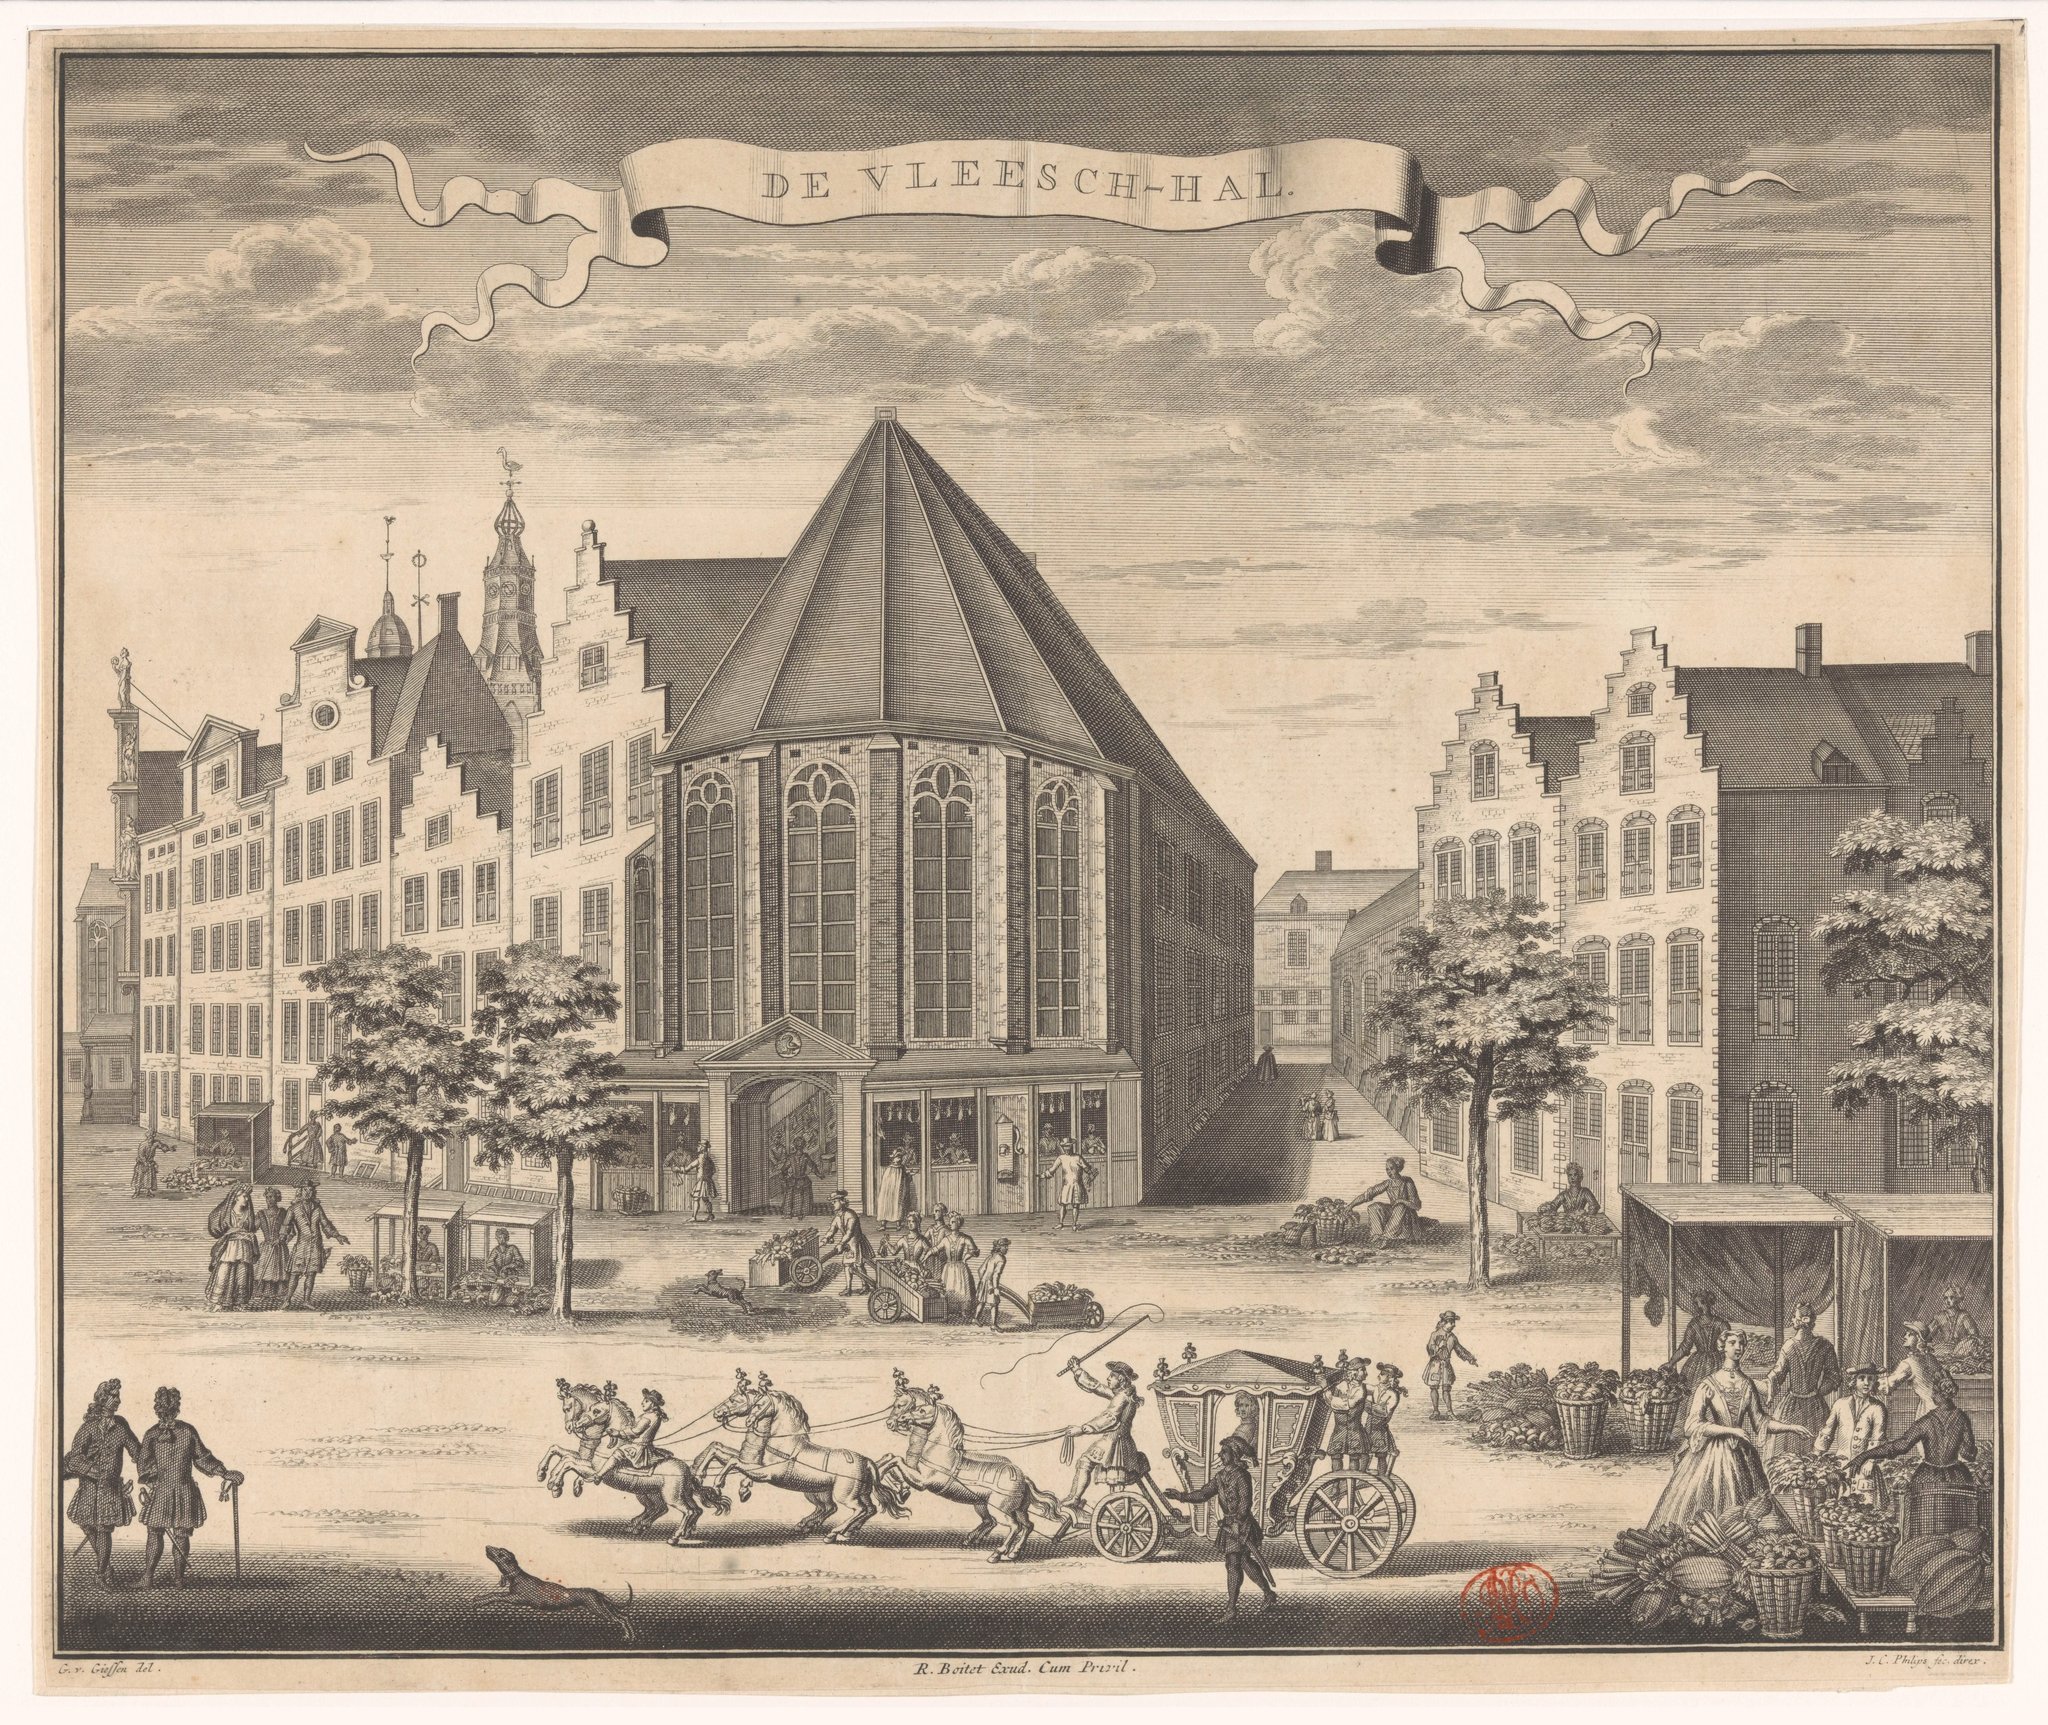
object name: book illustration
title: Gezicht op de Vleeshal te Den Haag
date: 1730-1736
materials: paper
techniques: engraving, etching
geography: the hague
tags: market, exterior ~ representation of a building, market-hall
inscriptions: collector's mark: Lugt 195, collector's mark: Lugt 2228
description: Gezicht op de Vleeshal te Den Haag, gevestigd in de voormalige Sint-Nicolaaskapel. Op straat verschillende marktkramen, figuren en een koets.